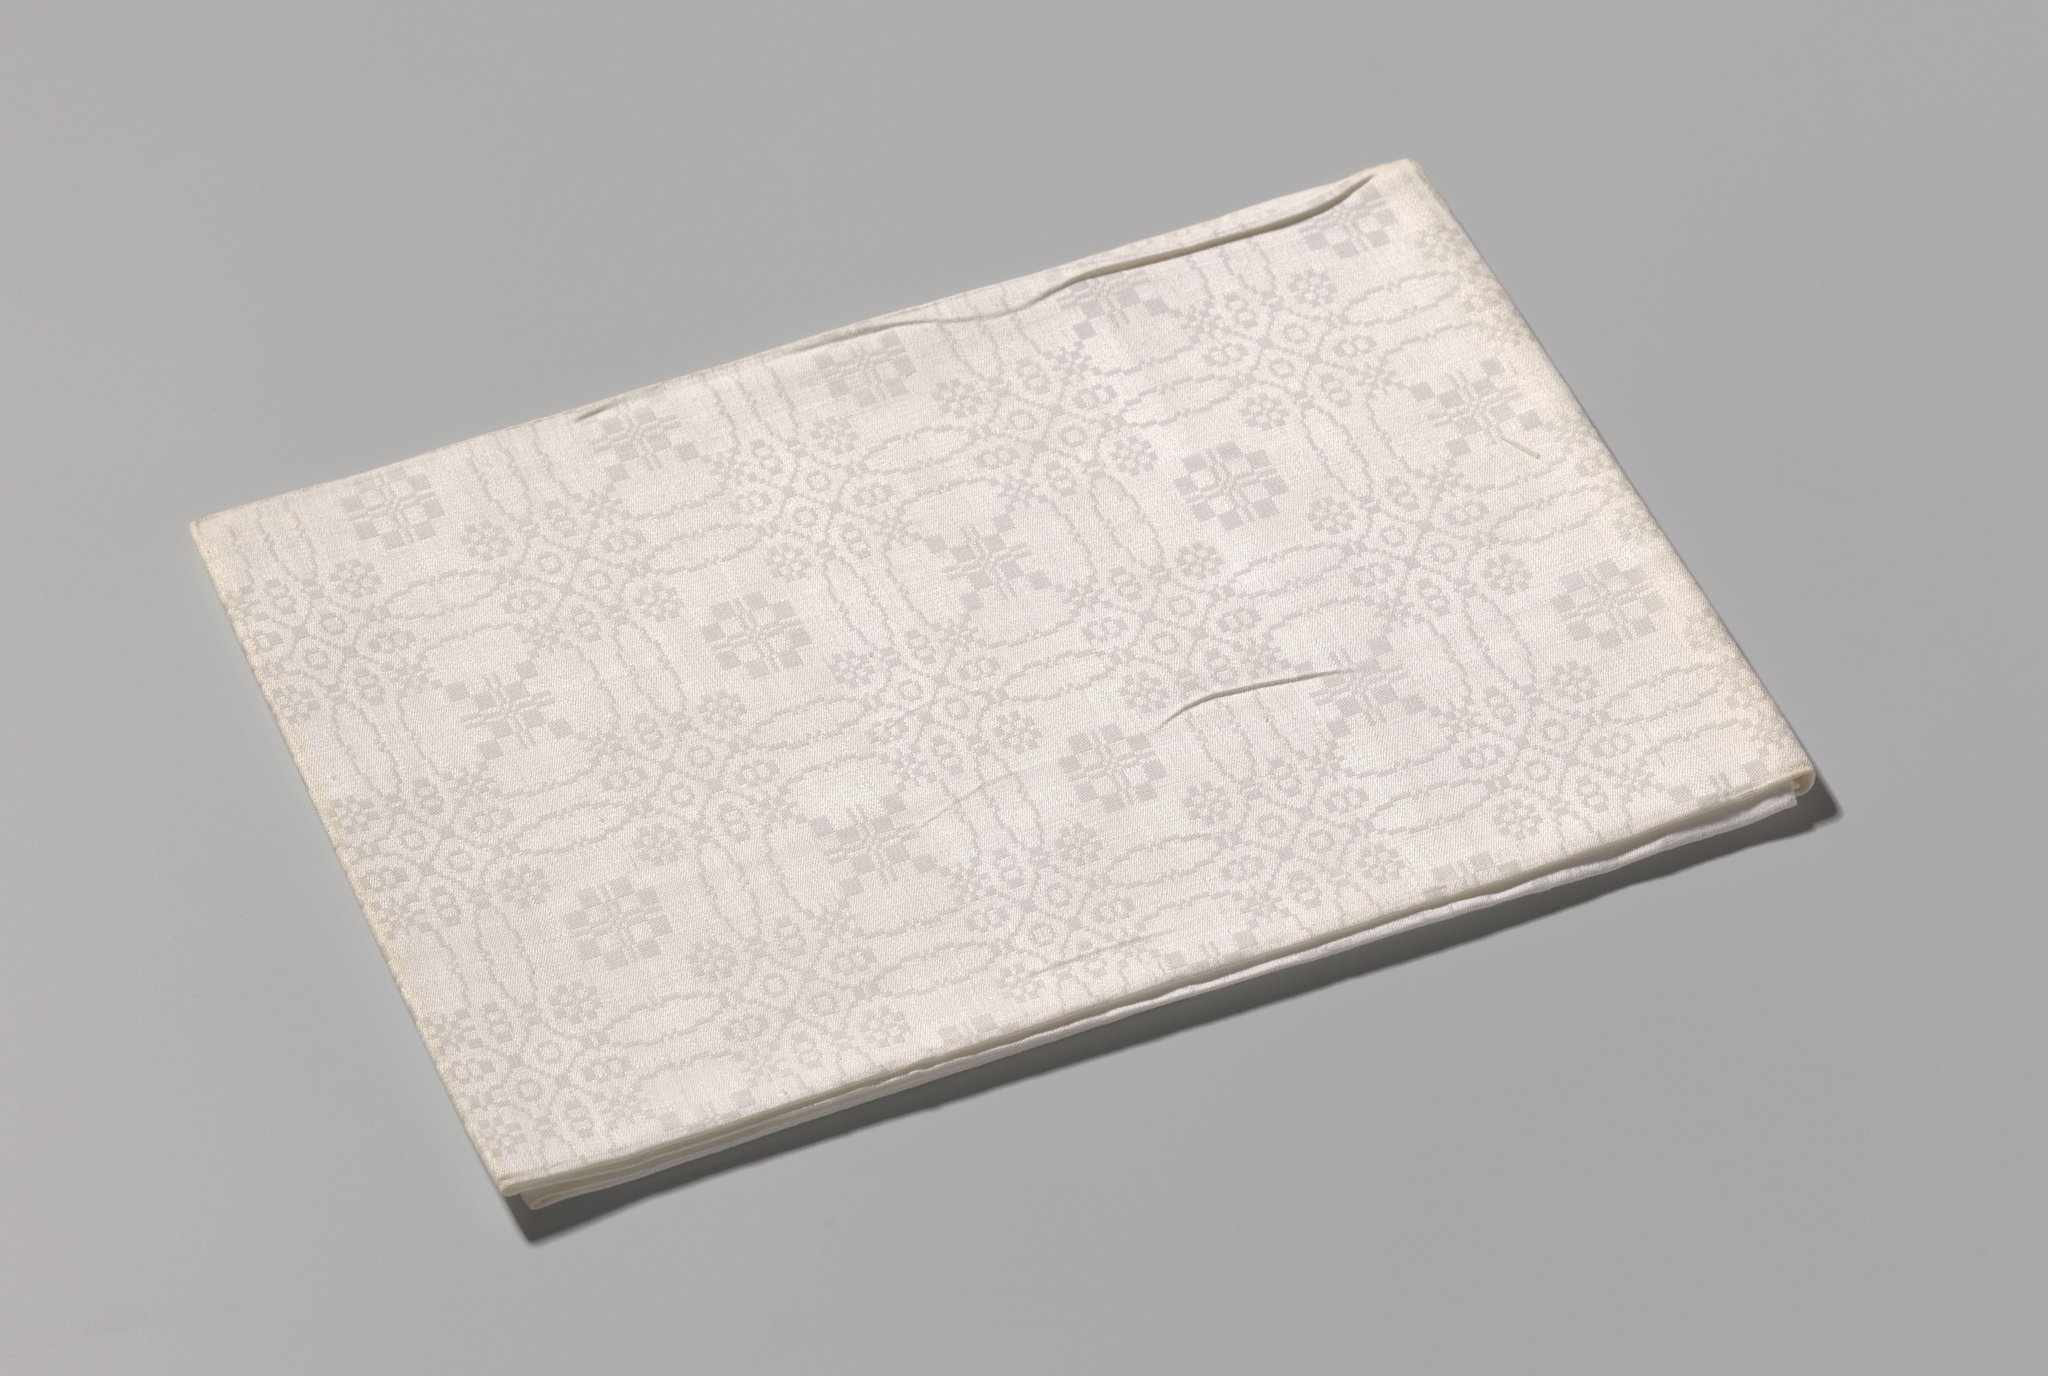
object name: napkin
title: Servet met pellenpatroon, gemerkt RR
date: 1650-1699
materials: linen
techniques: damask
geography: northern netherlands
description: Servet van wit linnen met pellen patroon:'omsingelde kattepoot en dubbel omsingeld tegenbeeld daarvan', merk kroon RR.